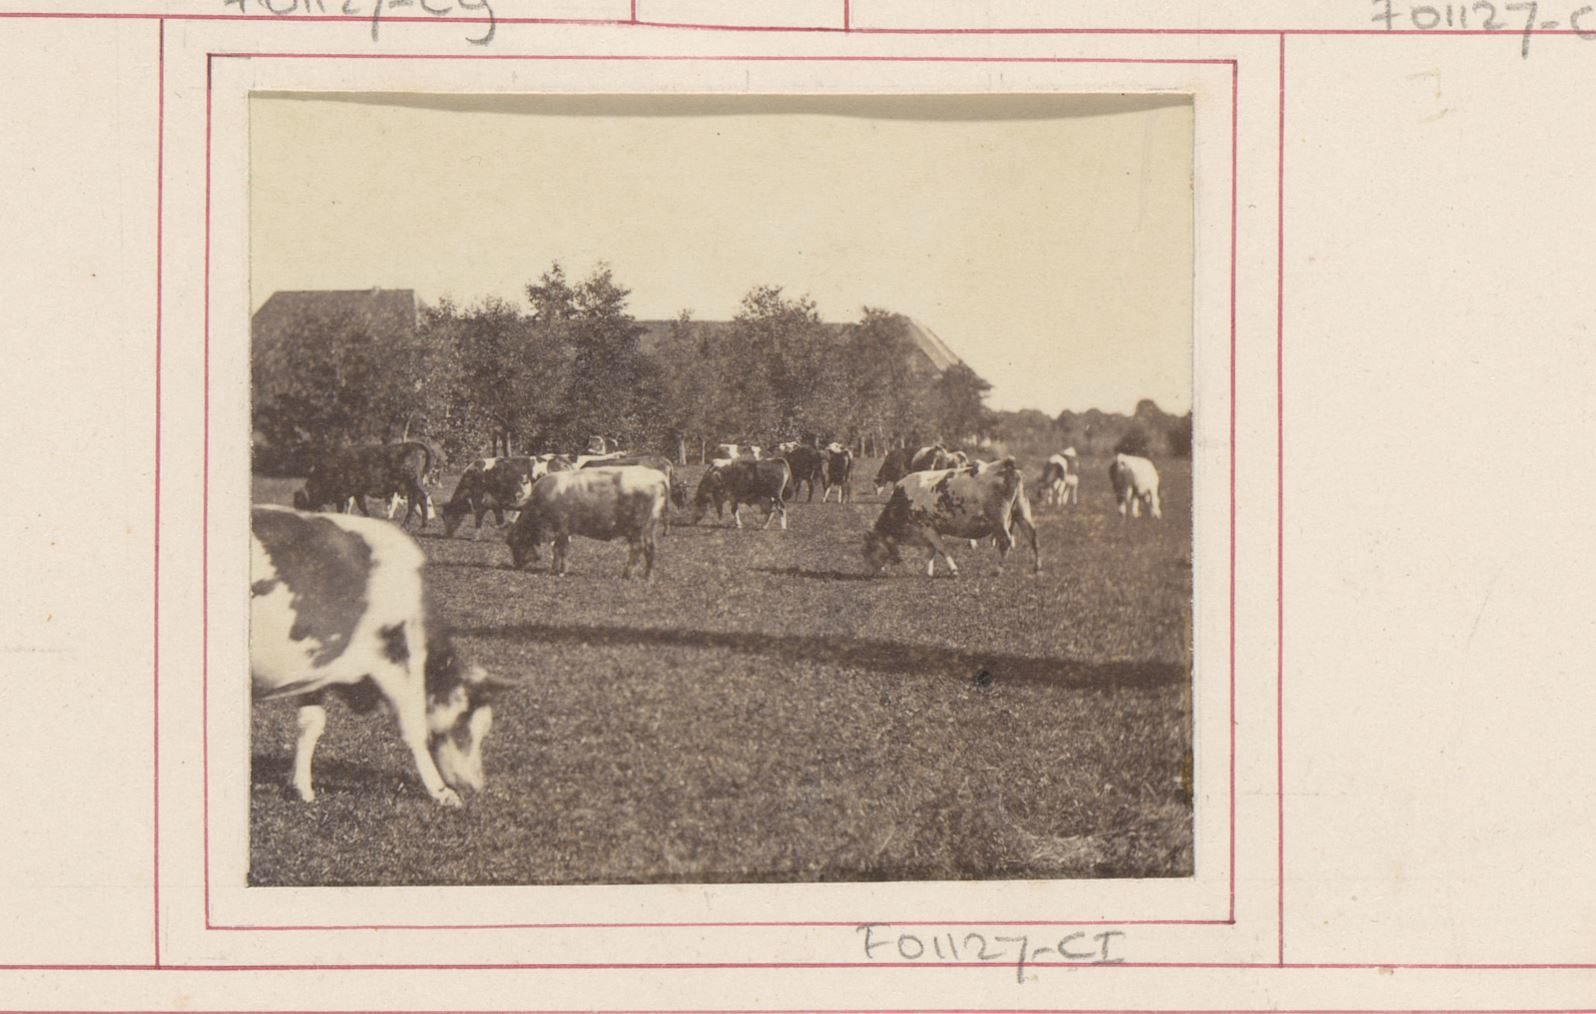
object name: photograph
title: Koeien in een weiland in de regio Leiden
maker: Anonymous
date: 1865-1875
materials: photographic support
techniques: albumen print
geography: south holland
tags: cow, meadow, pasture (+ landscape with figures, staffage)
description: Onderdeel van Album met foto's en litho's van bezienswaardigheden in Noord- en Zuid-Hollandse steden, schilderijen en klederdrachten.